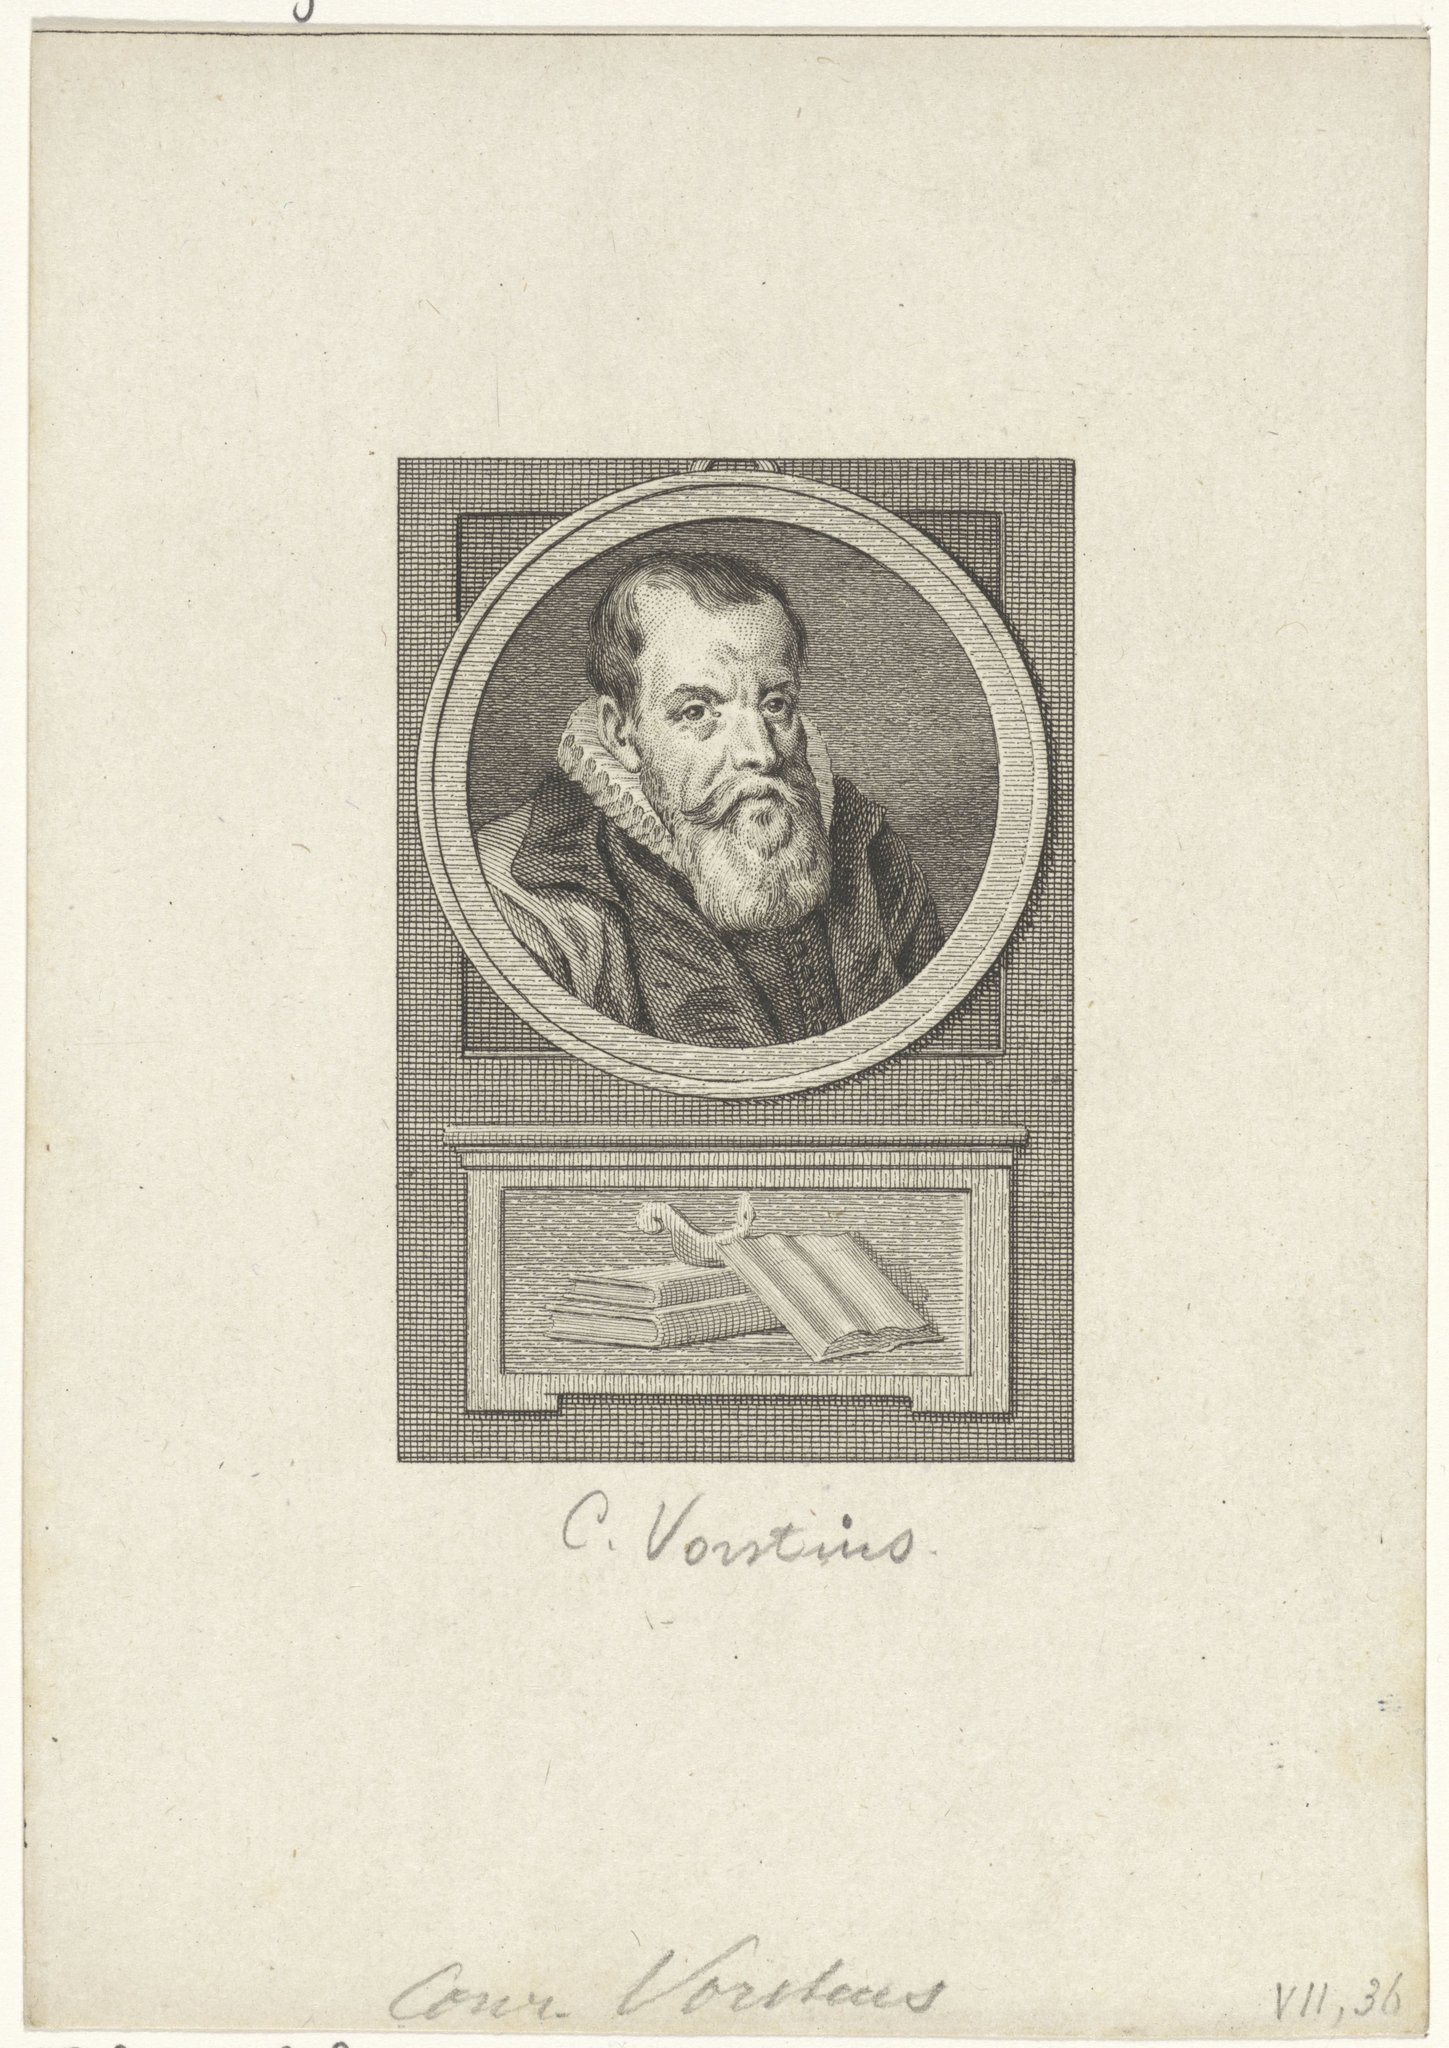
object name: print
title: Portret van Conradus Vorstius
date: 1783-1795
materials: paper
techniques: engraving, etching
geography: amsterdam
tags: oil-lamp (+ kindling a light; lit, burning light, lamp, candle), book - mm - book open, book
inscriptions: collector's mark: Lugt 2228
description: Latere staat prent gebruikt in: Fokke, Jan. Geschiedenissen der Vereenigde Nederlanden voor de vaderlandsche jeugd Ie-XXVste deel. Amsterdam: Johannes Allart, 1783-1795. Deel VII.